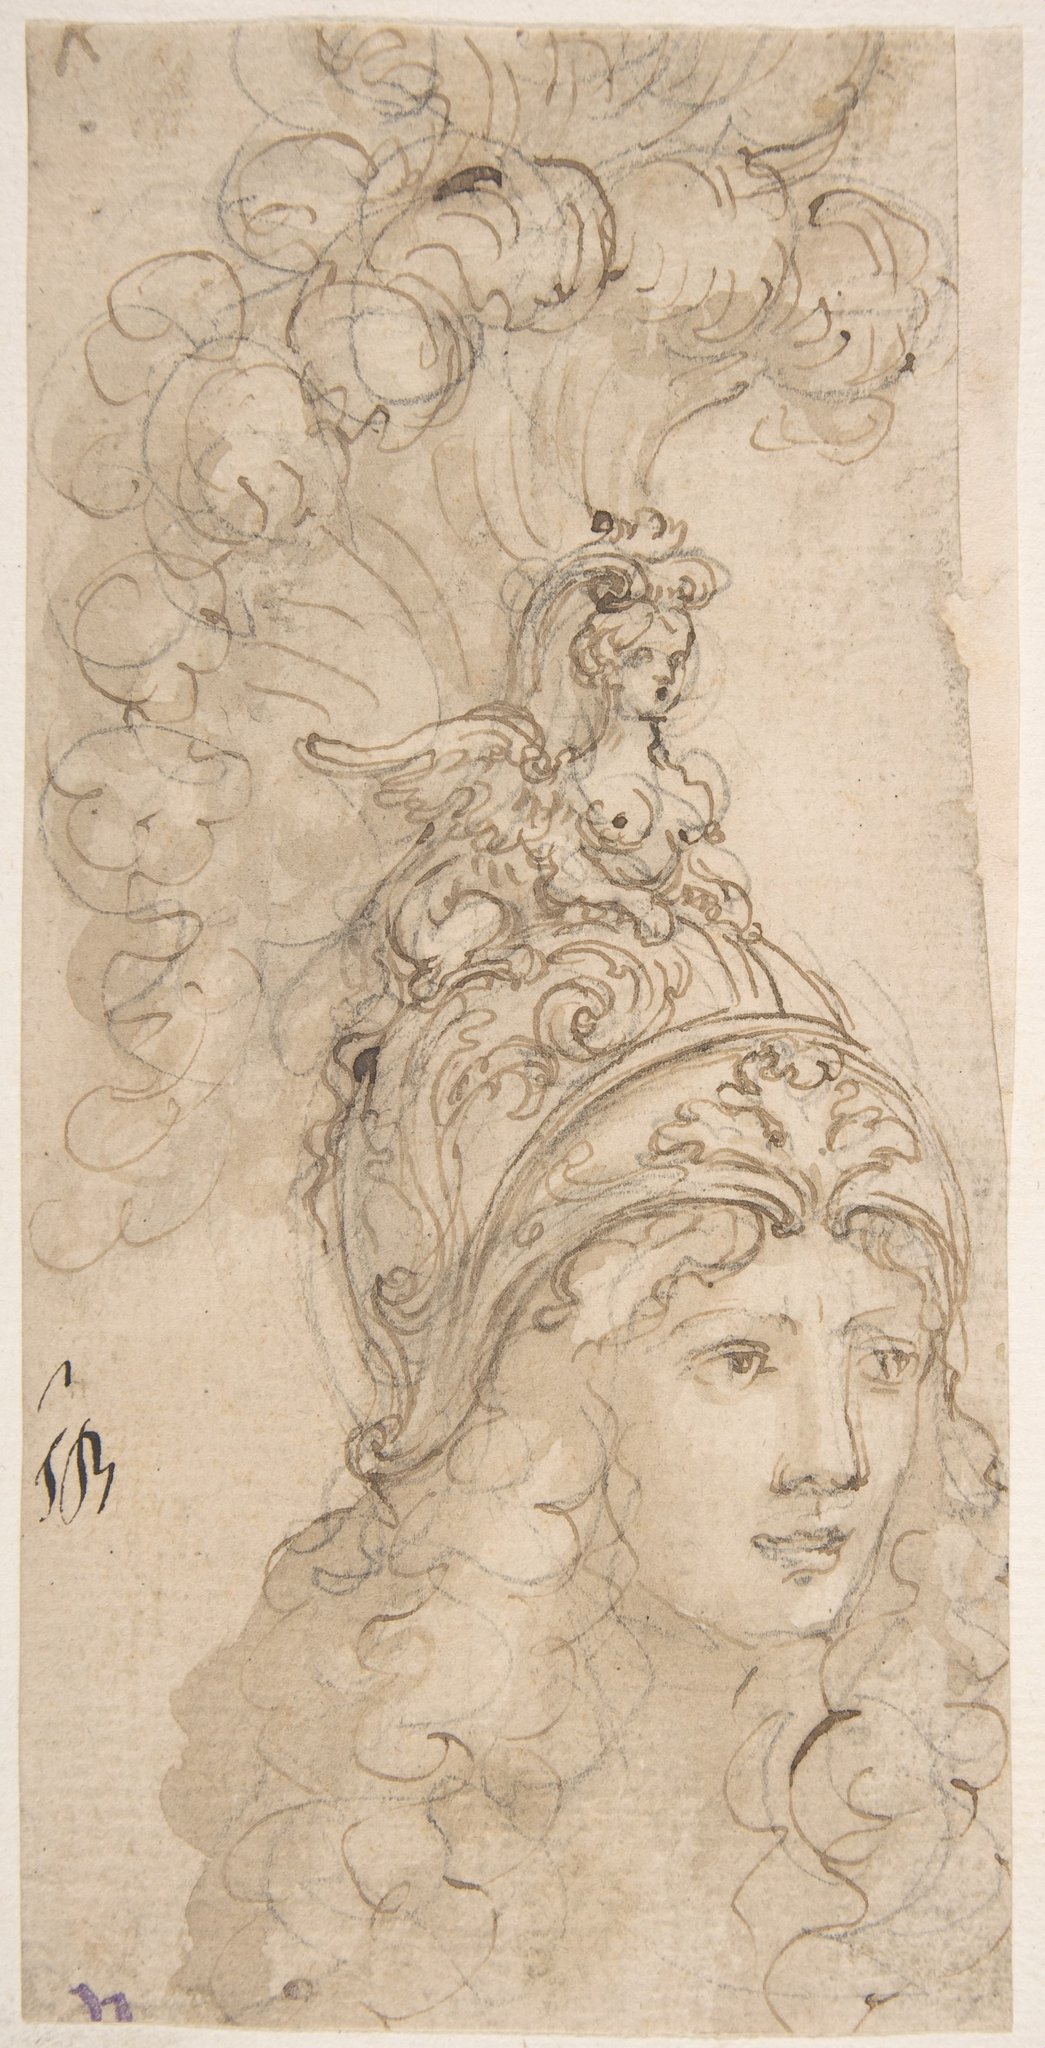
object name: drawing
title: Design for a Helmet with a Sphinx presented in 3/4 View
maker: giovanni battista foggini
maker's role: artist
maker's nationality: italian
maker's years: 1652-1725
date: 1672-1725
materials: chalk, ink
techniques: brush, pen, wash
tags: helmets,portraits,women,sphinx